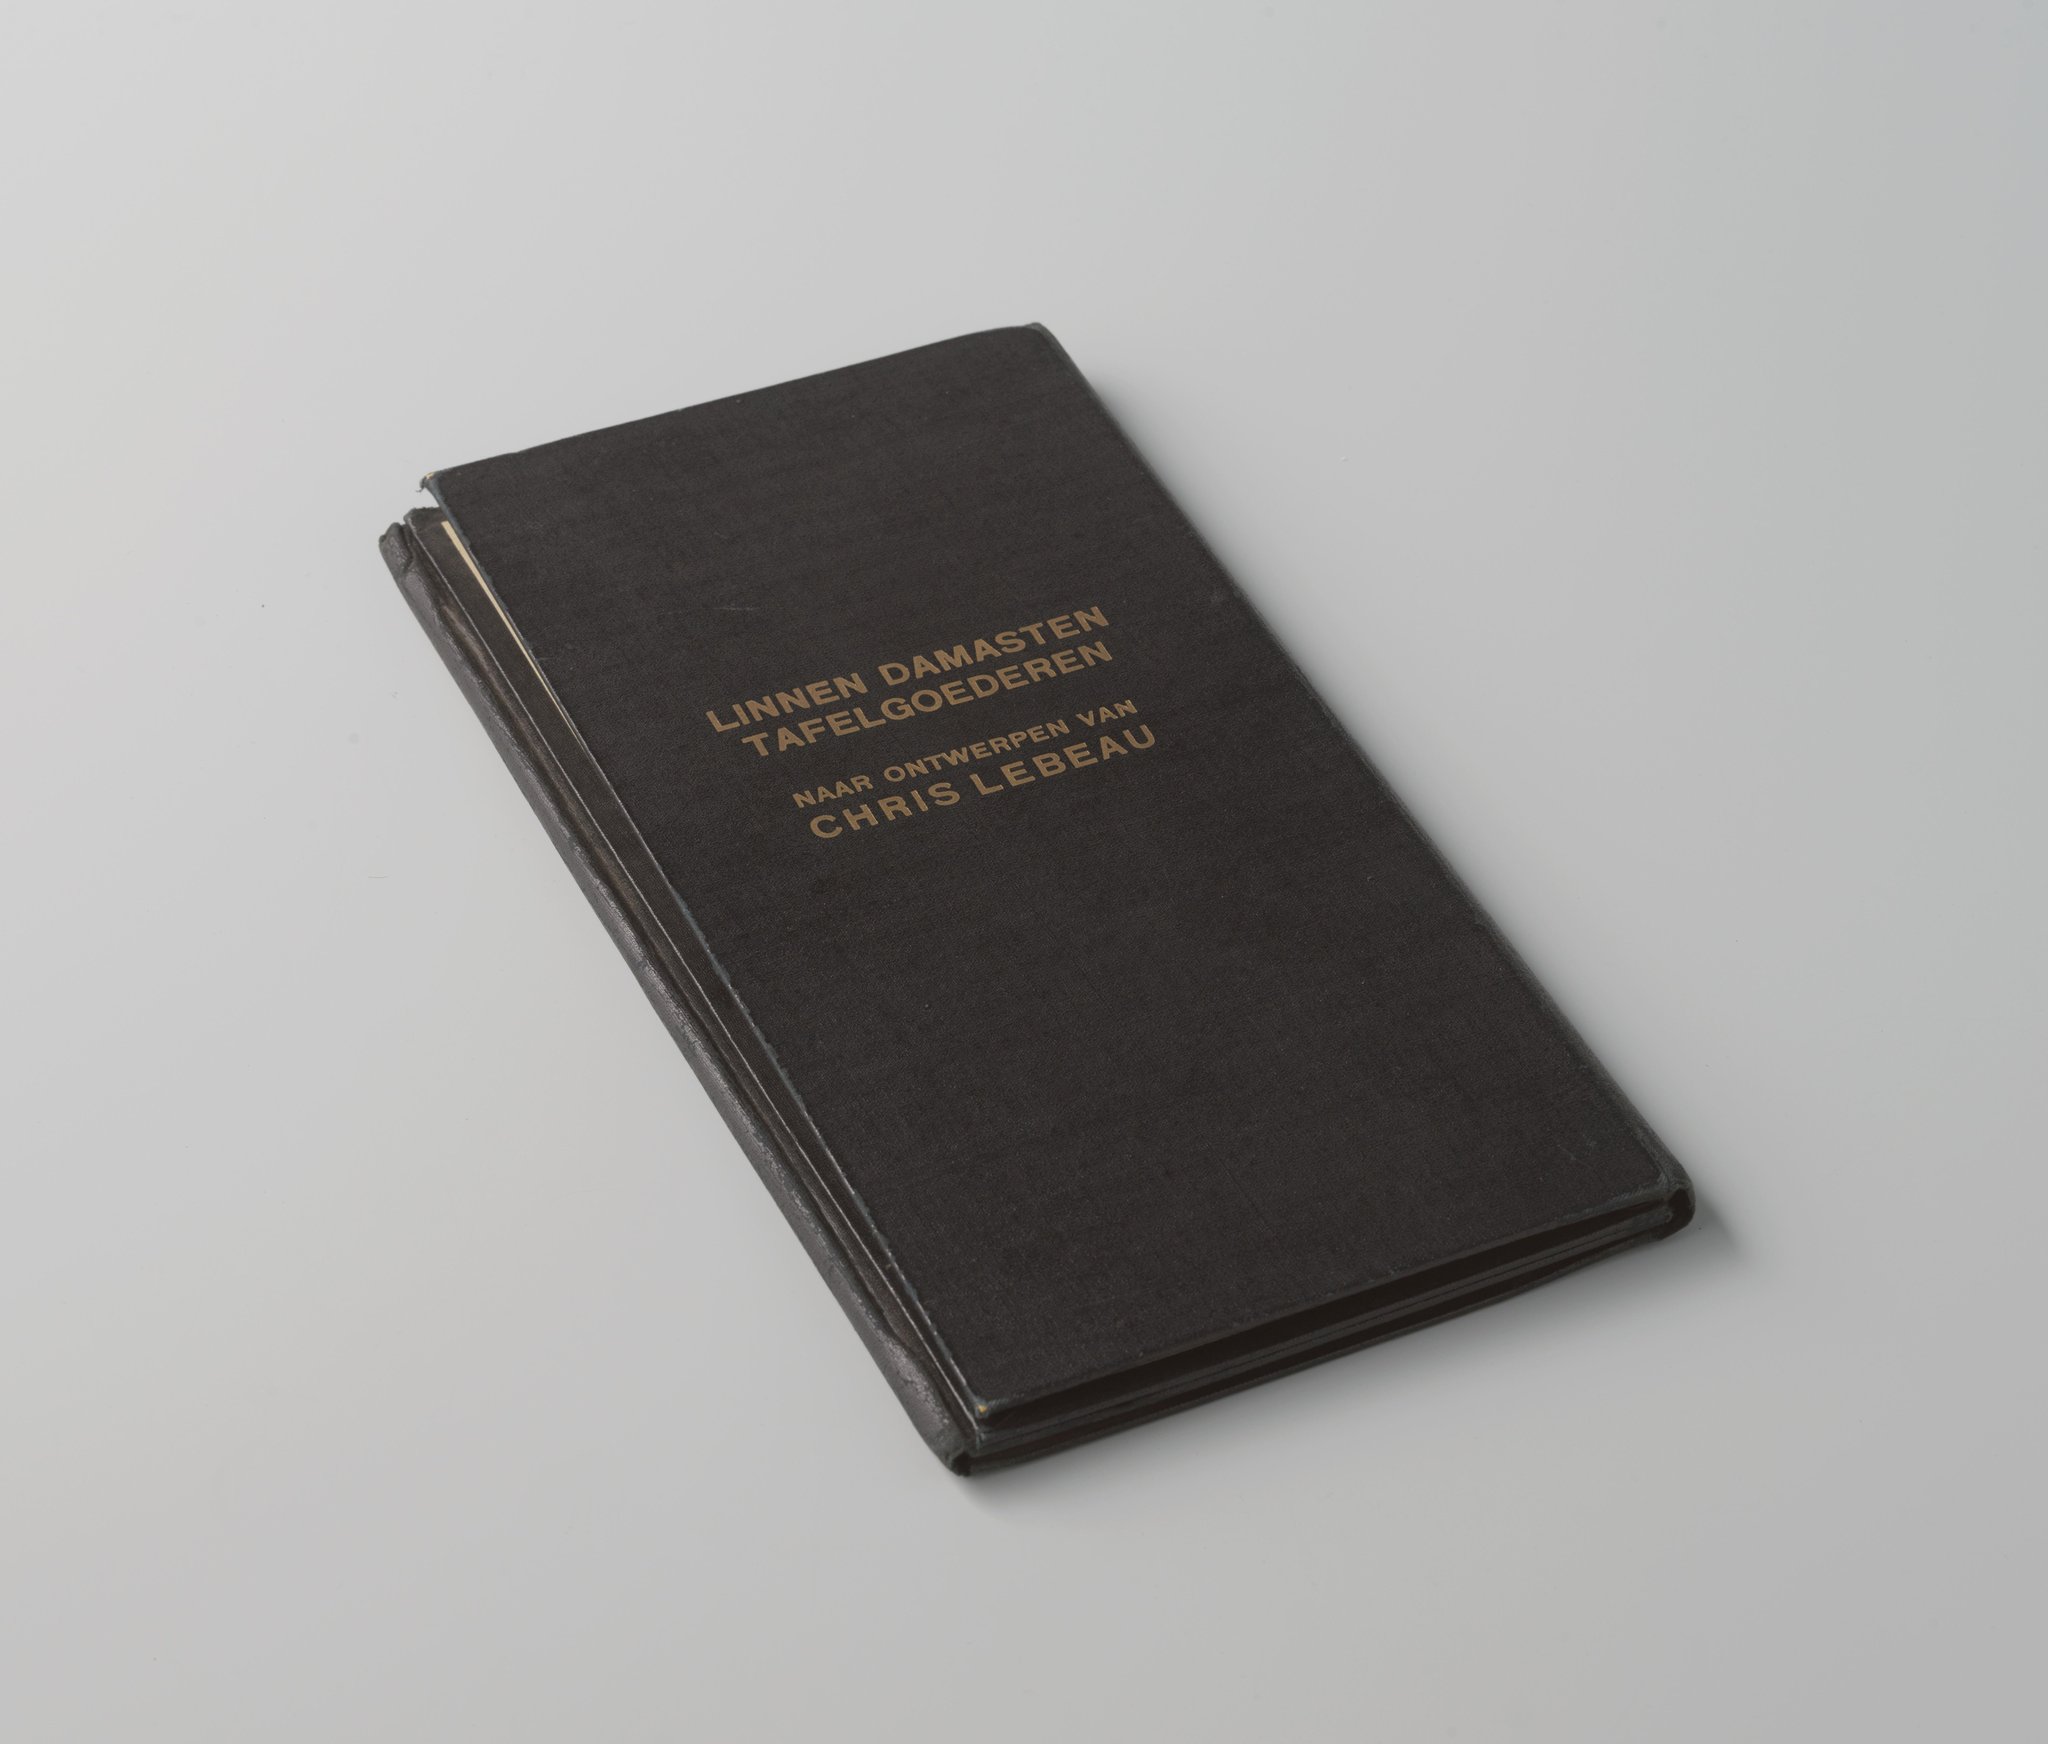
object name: pattern book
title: Stalenboek met damaststalen en foto's, ontwerpen Chris Lebeau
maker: chris lebeau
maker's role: draughtsman, print maker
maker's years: 1878-1945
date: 1888-1945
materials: cardboard, linen, paper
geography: eindhoven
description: Stalenboek met negen damaststalen en foto's, ontwerpen Chris Lebeau, dessin 201 etc. Van Dissel & Zonen, Eindhoven.